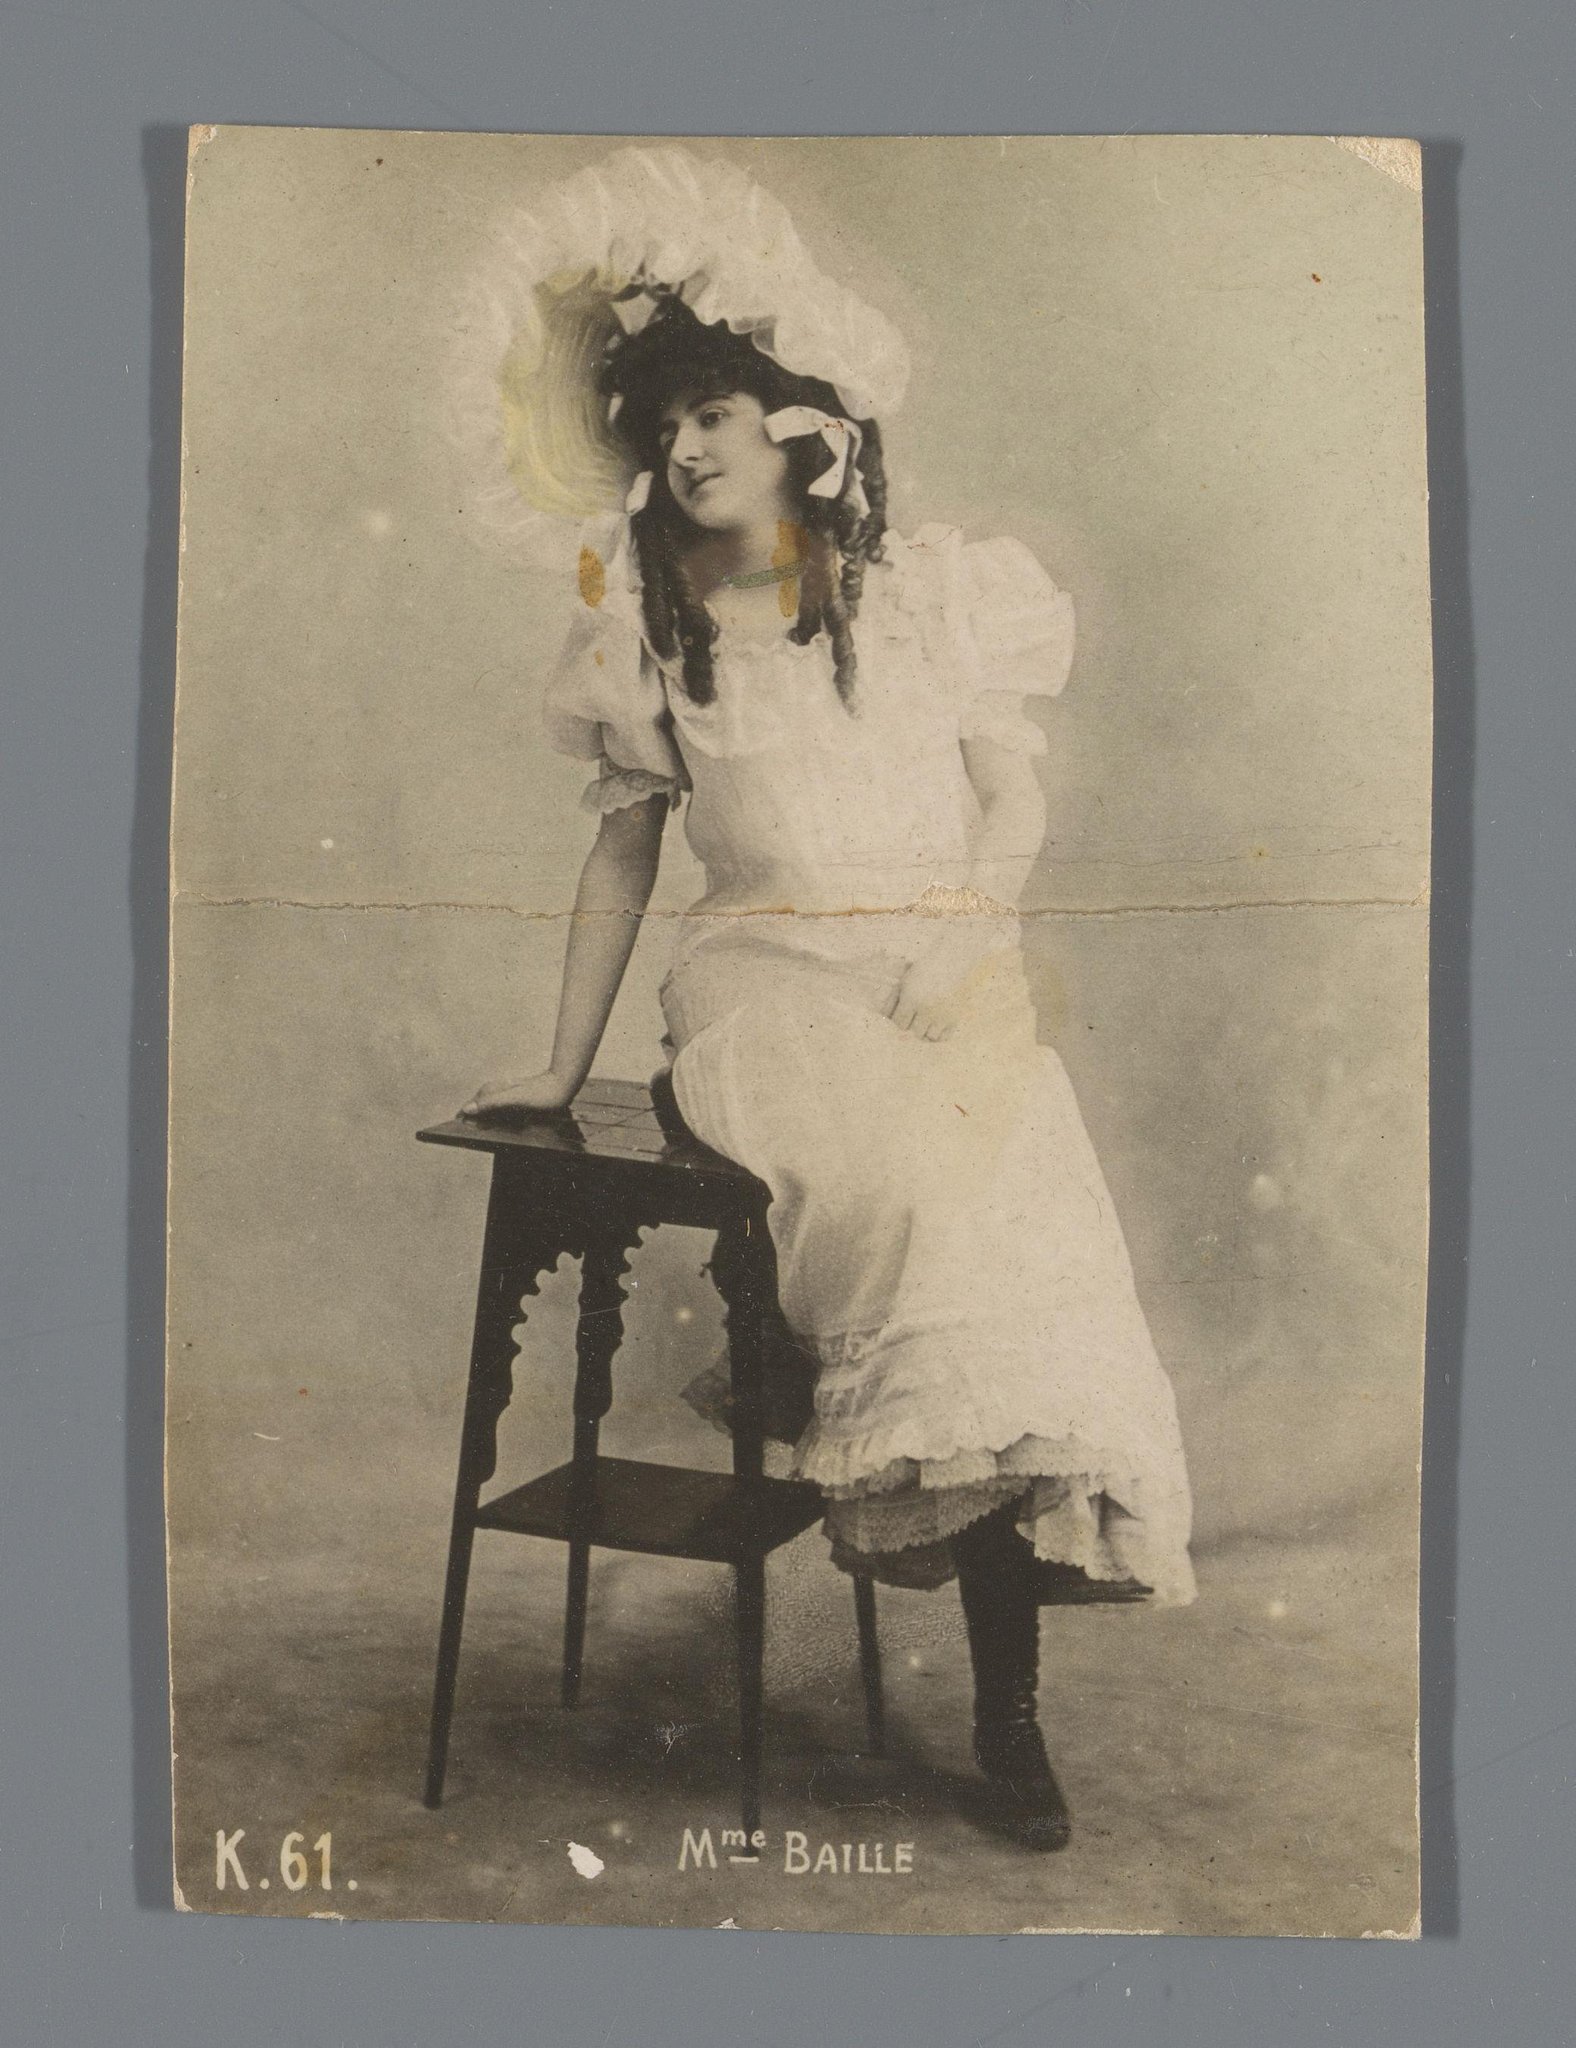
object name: photograph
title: Portret van een onbekende vrouw, aangeduid als Madame Baille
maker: Anonymous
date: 1890-1910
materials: photographic support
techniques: gelatin silver print, hand coloring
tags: historical persons - bb - woman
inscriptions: inscription: ‘K. 61.’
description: Dergelijke foto's stonden bekend als 'zwartjes'. Men verkreeg ze bij aanschaf van bepaalde merken thee, cacao, sigaretten, beschuit, etc. om te verzamelen. Er waren speciaal voor de 'zwartjes' vervaardigde verzamelalbums in omloop.